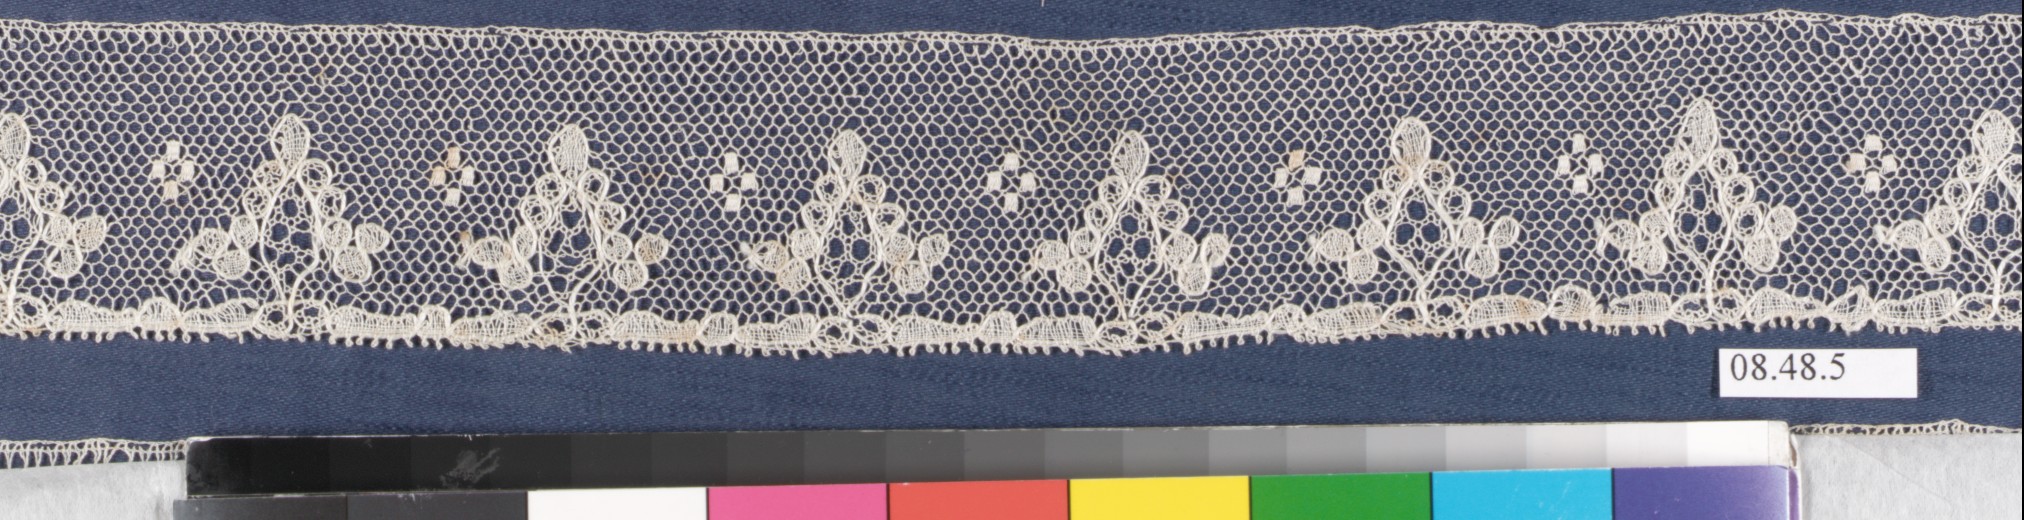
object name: edging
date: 1801-1900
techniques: lace